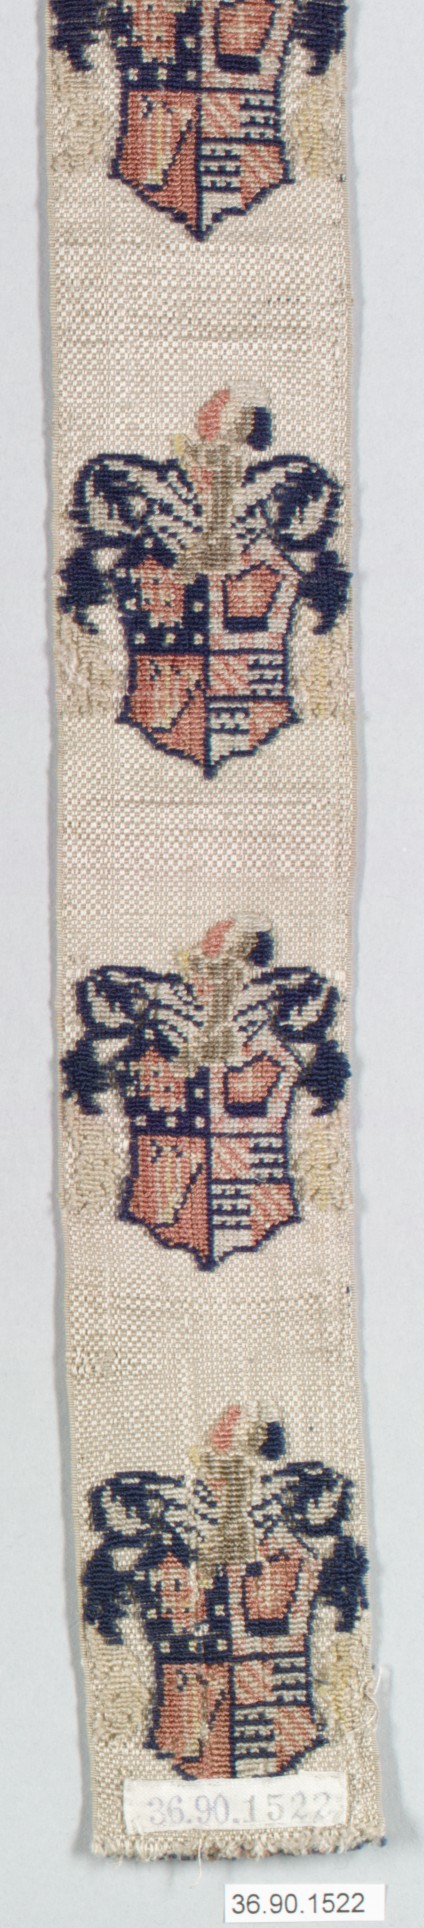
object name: galloon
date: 1701-1900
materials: silk